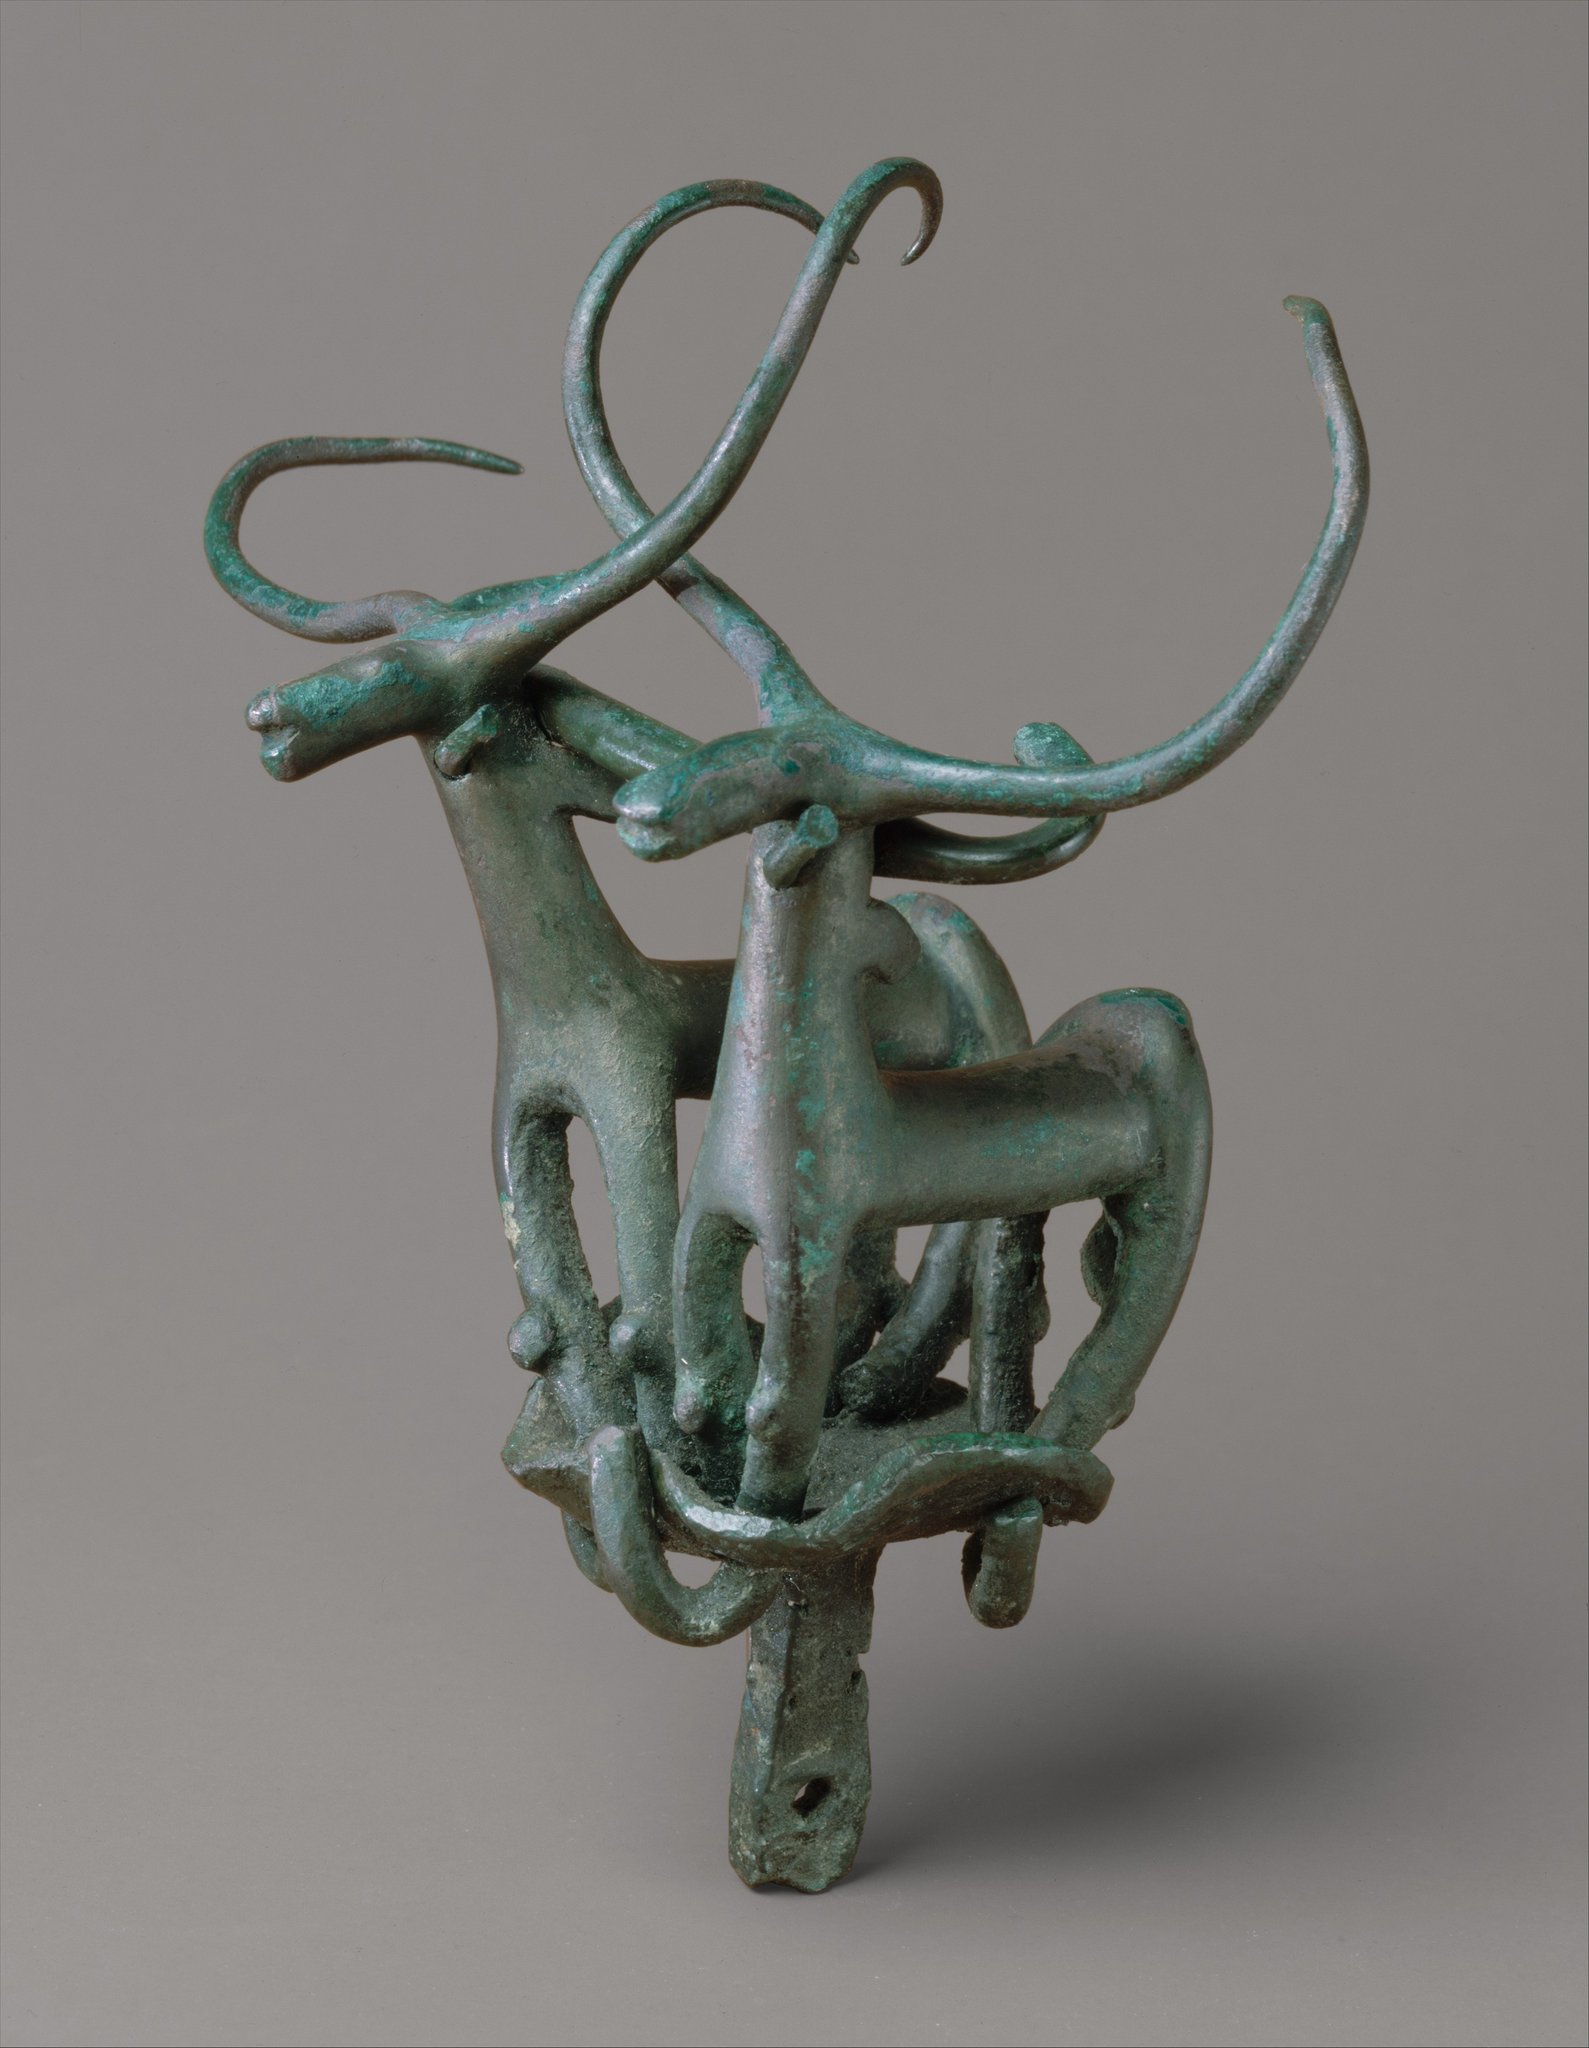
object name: standard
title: Standard with two long-horned bulls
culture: hattian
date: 2300-2000 BCE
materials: copper alloy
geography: central anatolia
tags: bulls